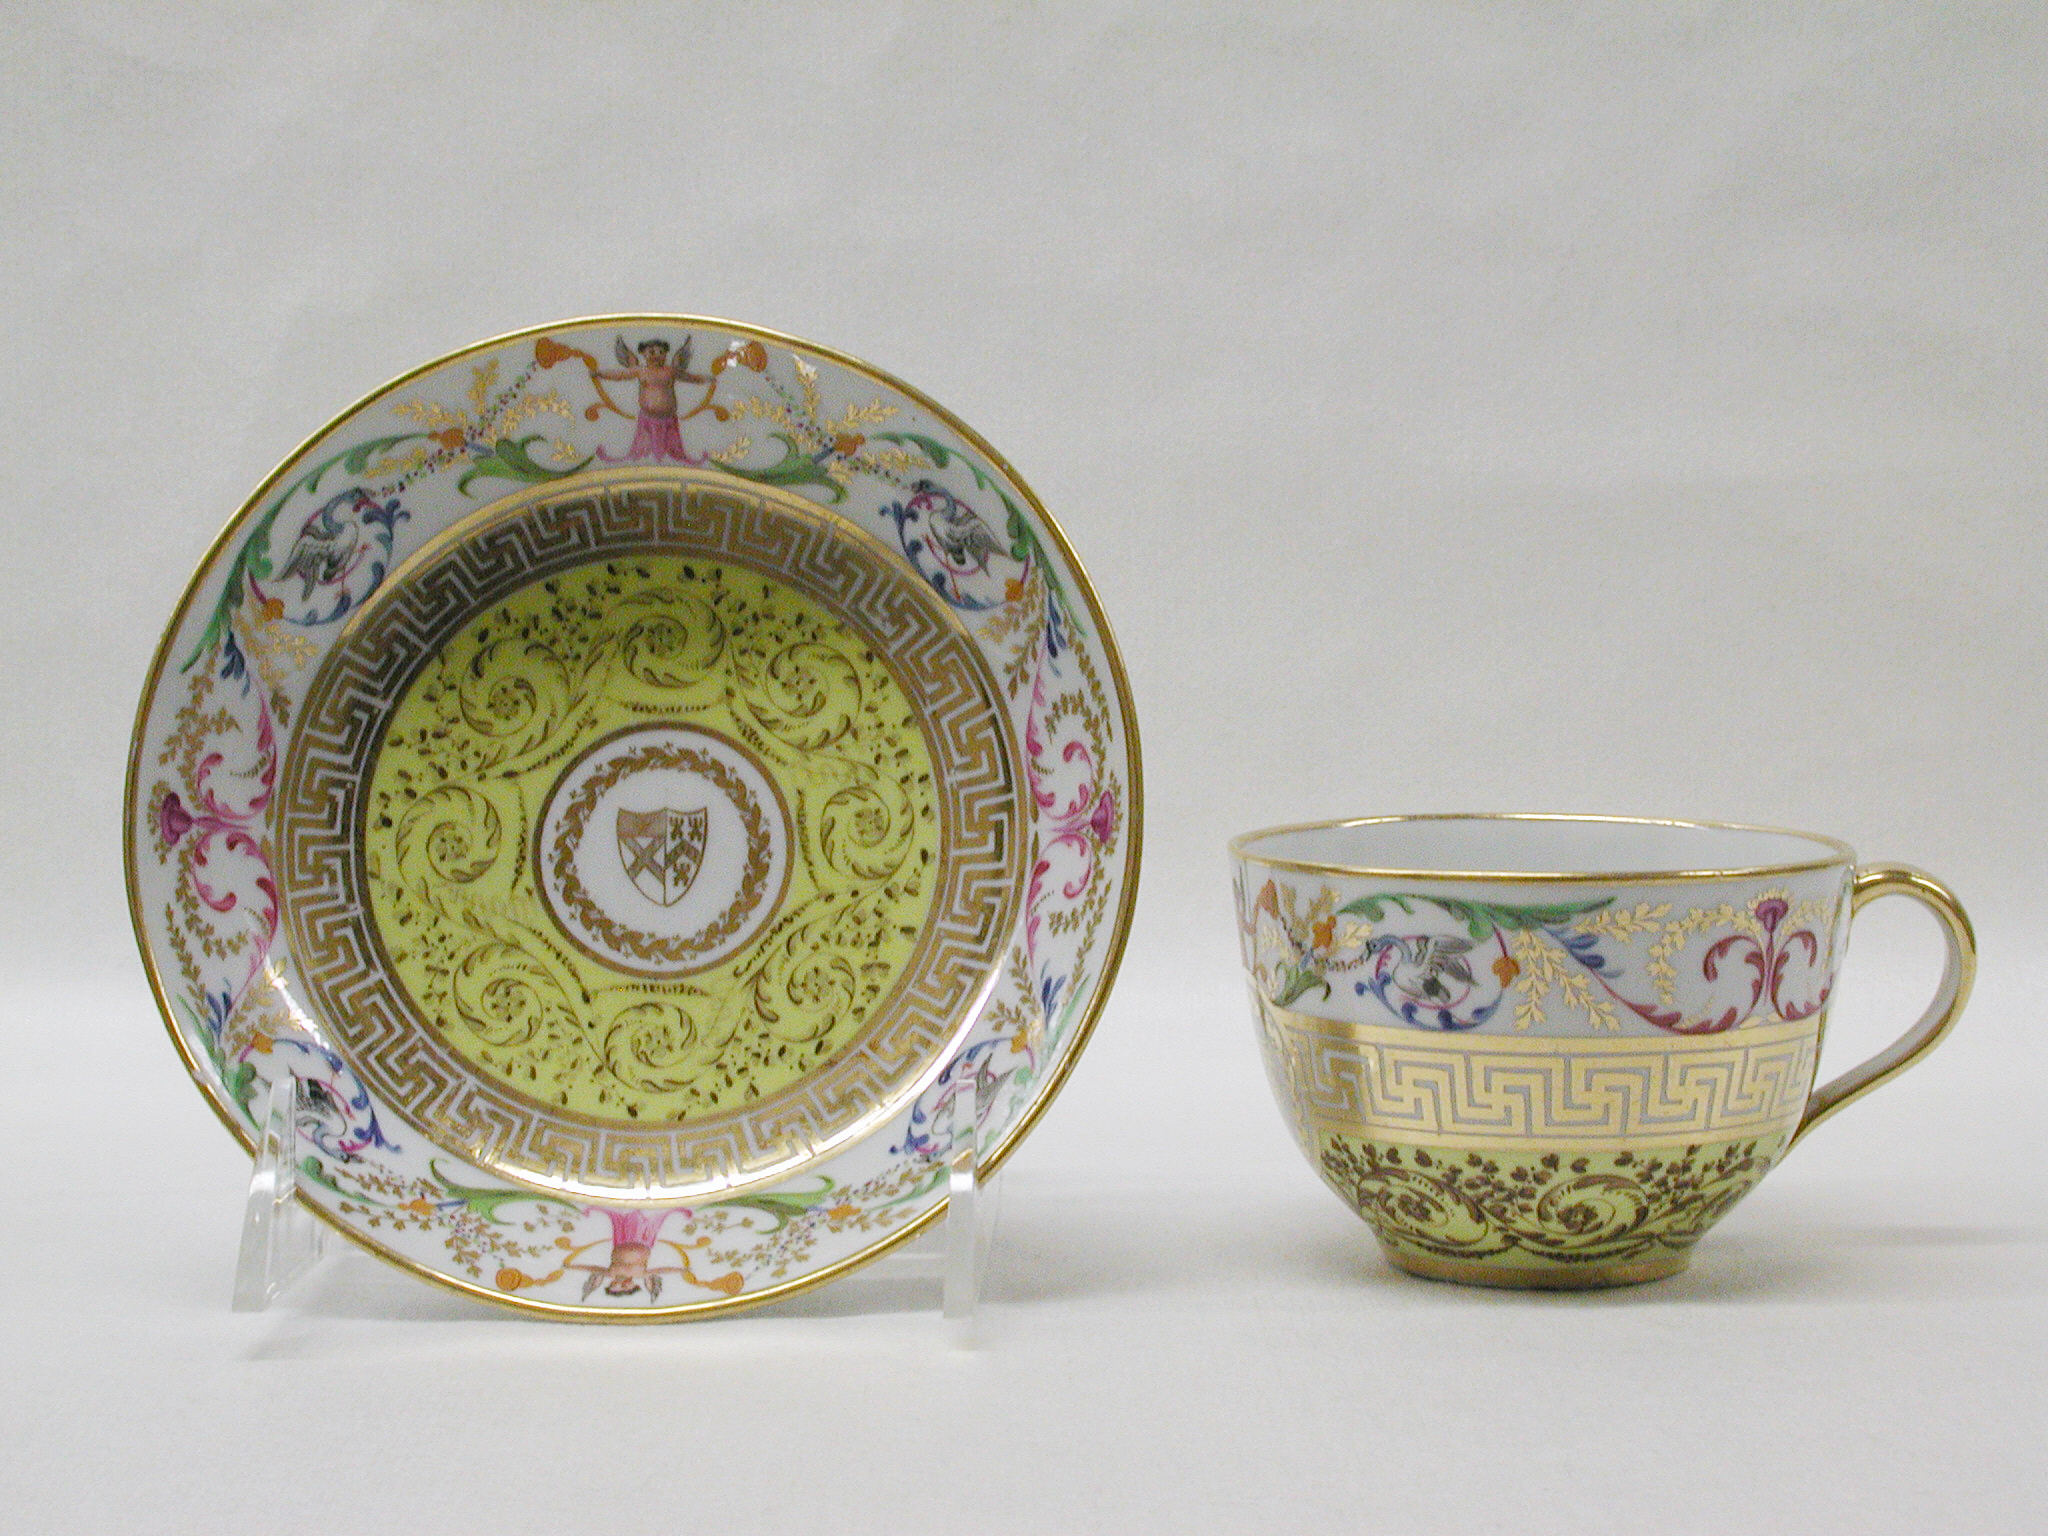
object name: teacup and saucer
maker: barr, flight and barr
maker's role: factory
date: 1807-1810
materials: porcelain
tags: birds,coat of arms